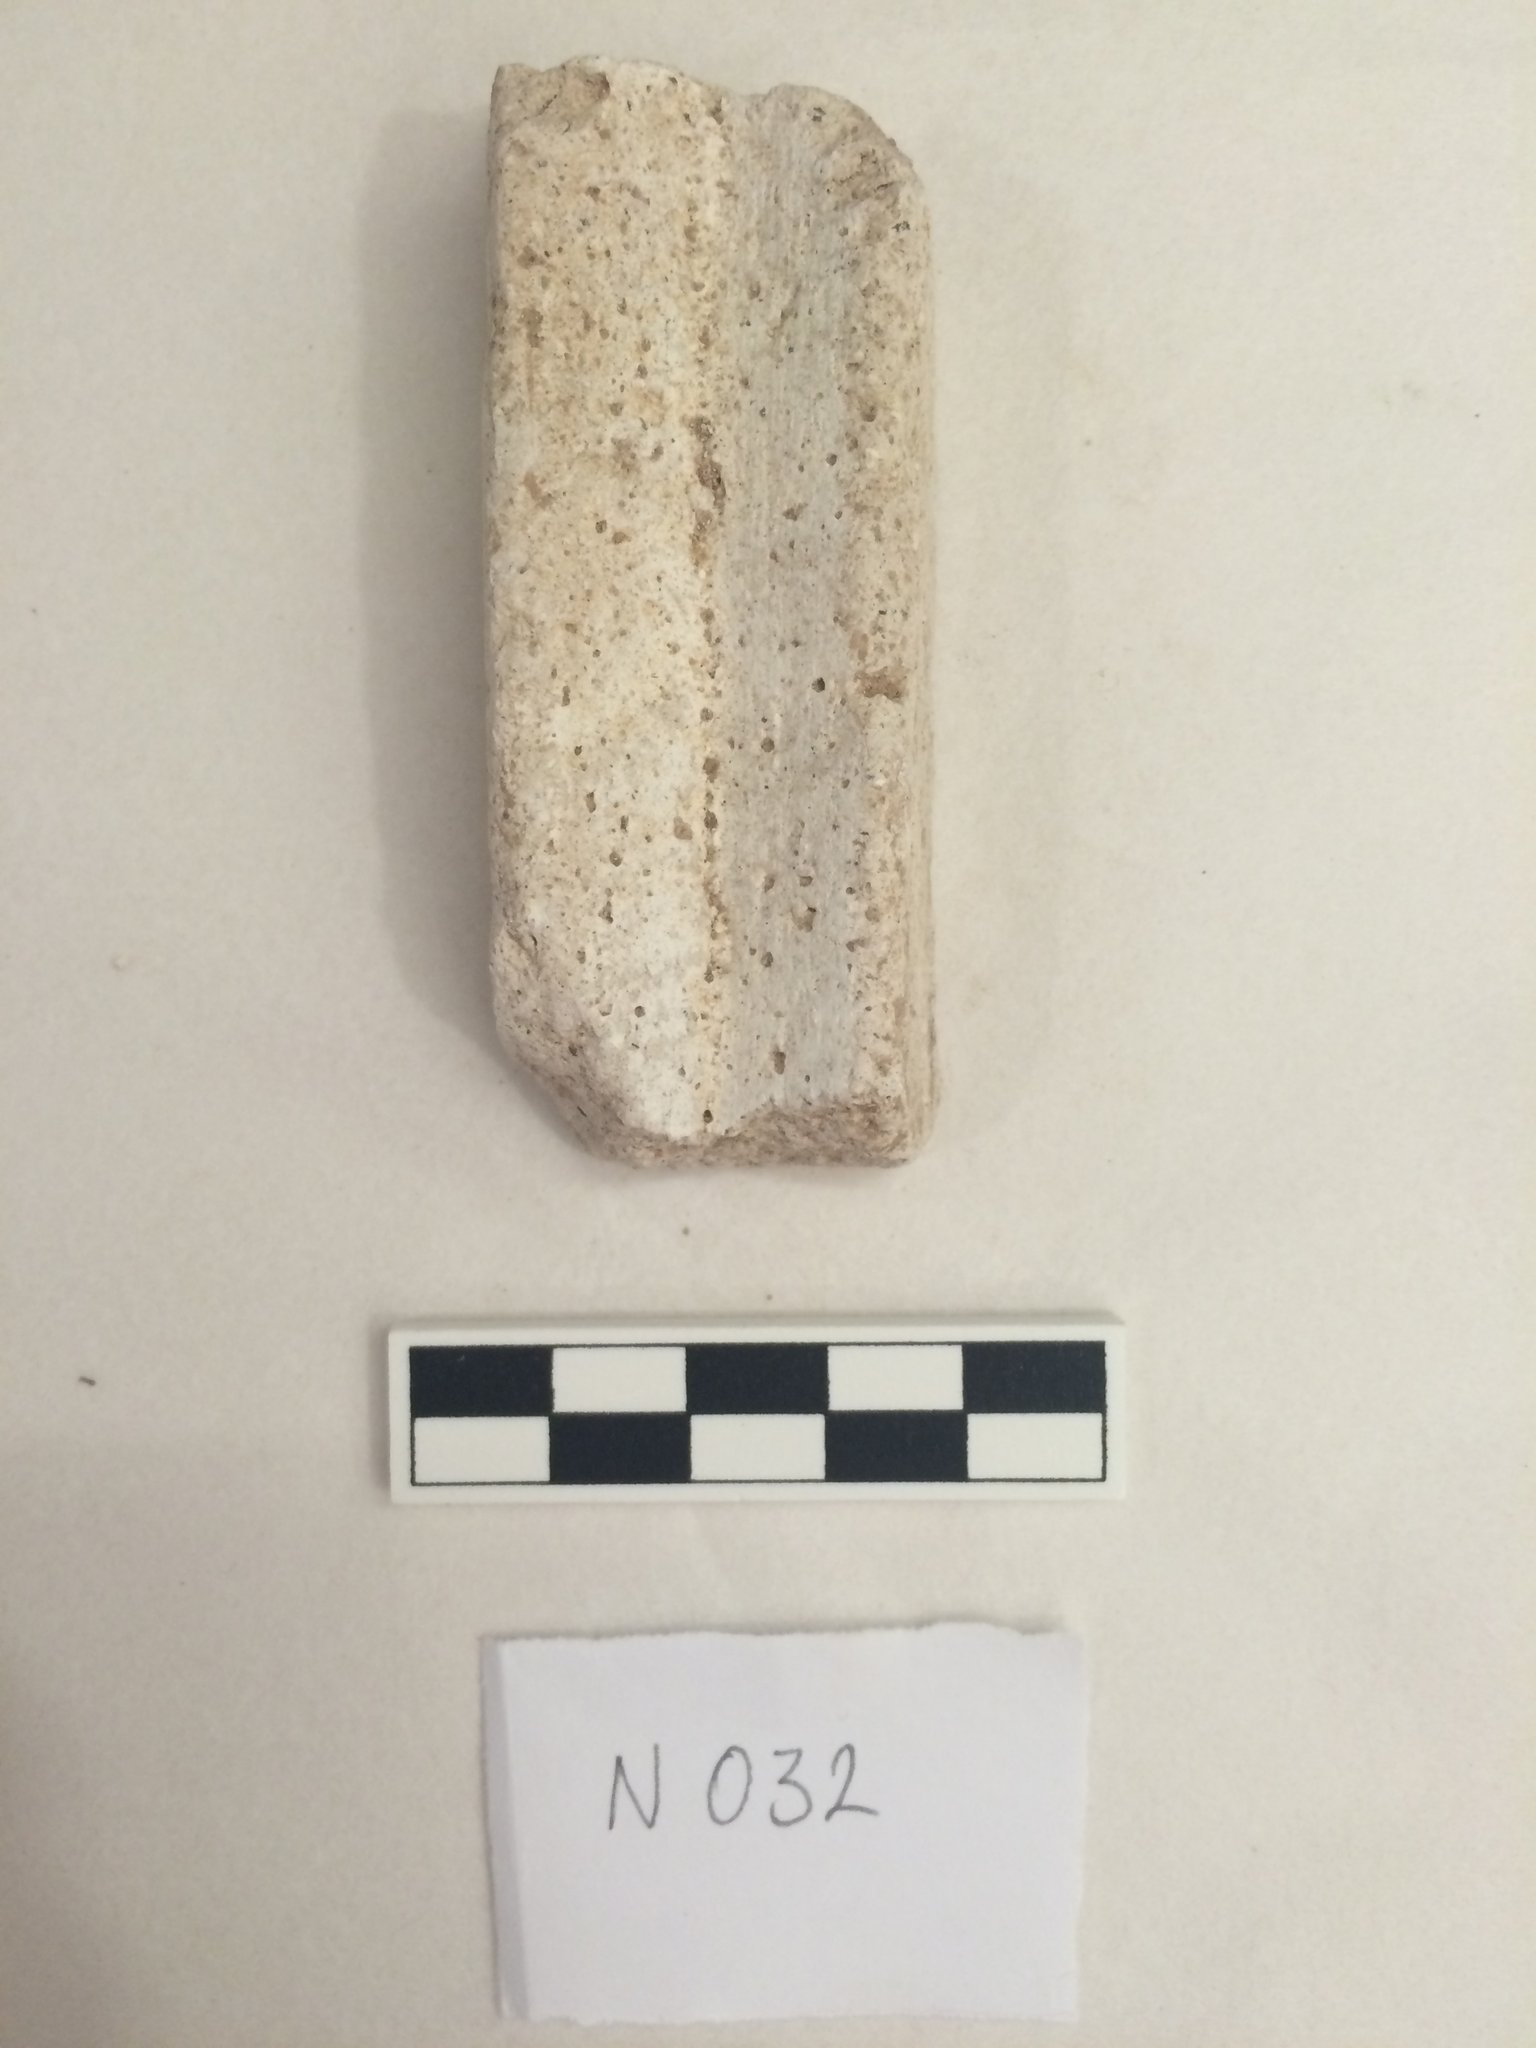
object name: fragment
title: Stucco Fragment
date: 701-1200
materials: plaster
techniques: carving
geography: iran